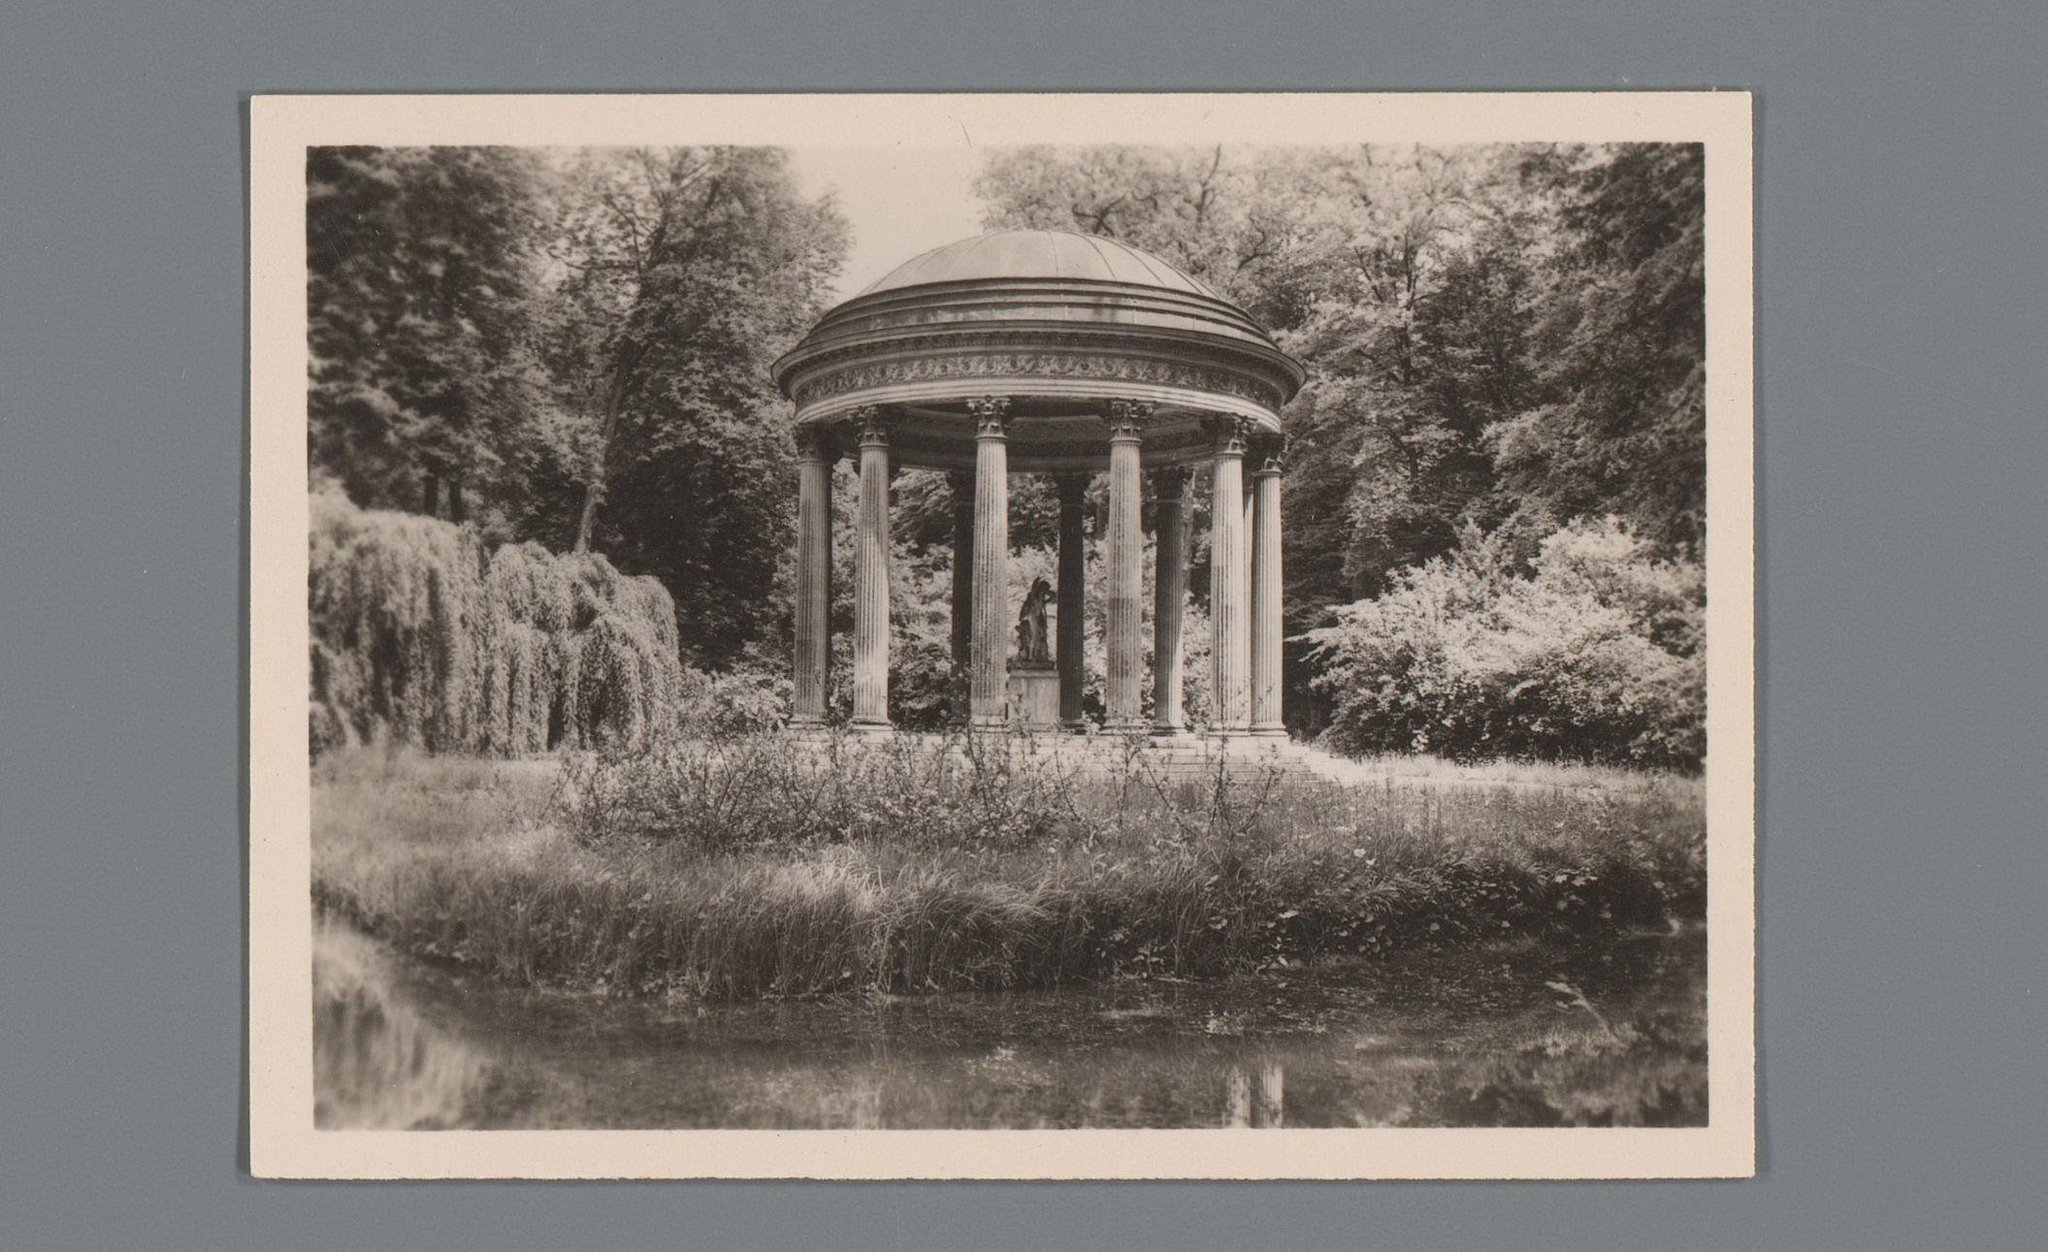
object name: photograph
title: Palais du Petit Trianon - Le Temple de l'Amour / Cottages - Temple of Love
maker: Anonymous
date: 1900-1920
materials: paper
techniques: gelatin silver print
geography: versailles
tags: architectural folly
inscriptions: number: ‘17’